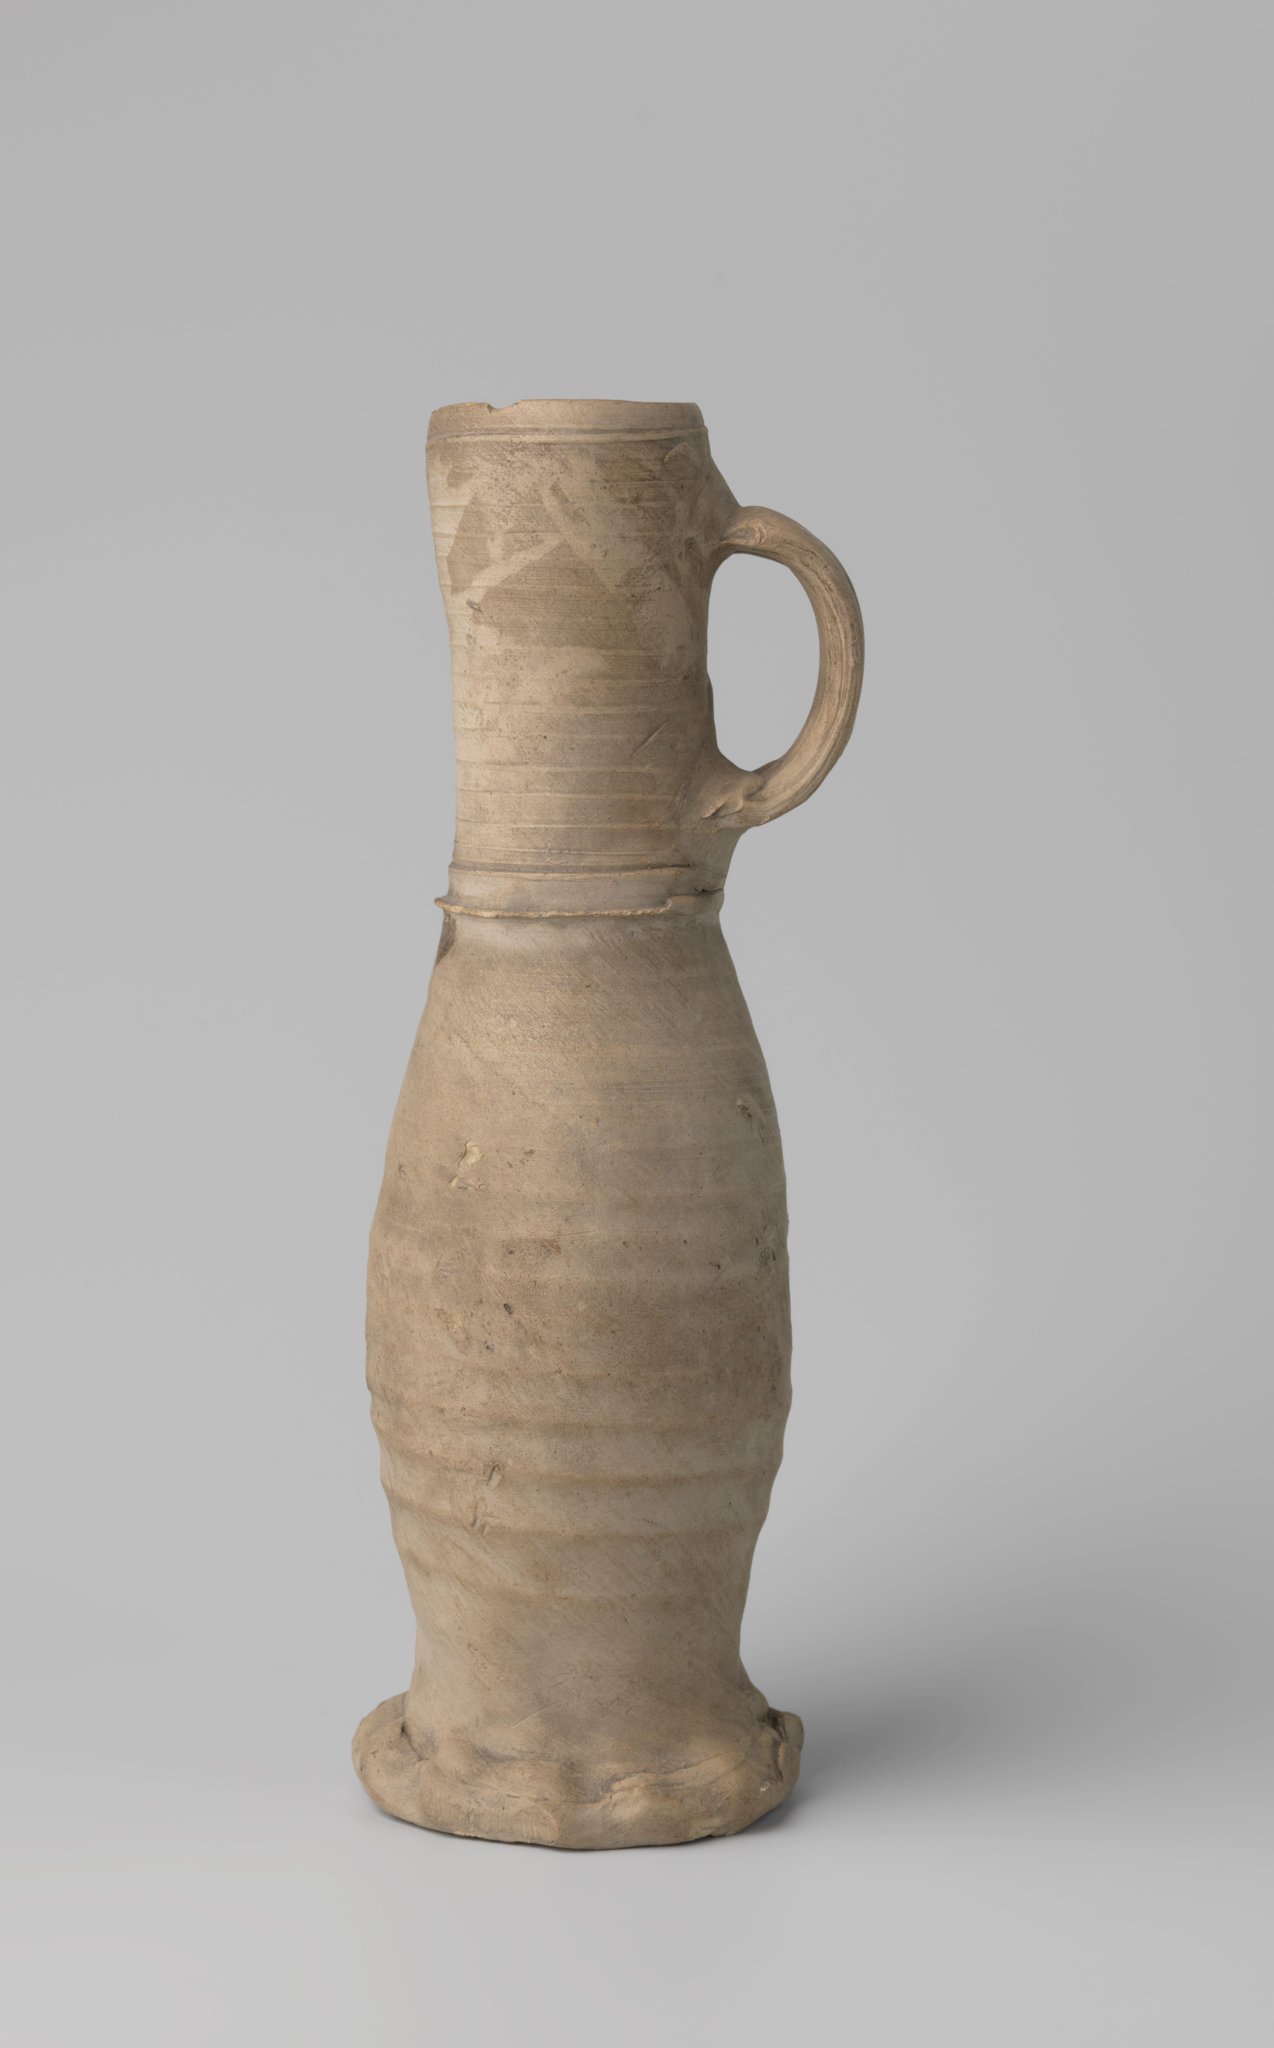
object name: jacobakan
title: Jug or 'Jacobakan'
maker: Anonymous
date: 1450-1549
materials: stoneware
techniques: firing, forming, turning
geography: siegburg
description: Geribde, smalle kan (Jacobakan) van steengoed op gegolfde voet met een eivormig lichaam en lange nek. Het C-vormige oor is bevestigd aan de nek. De kan is versierd met draairingen en een profiel op de schouder. Siegburg.